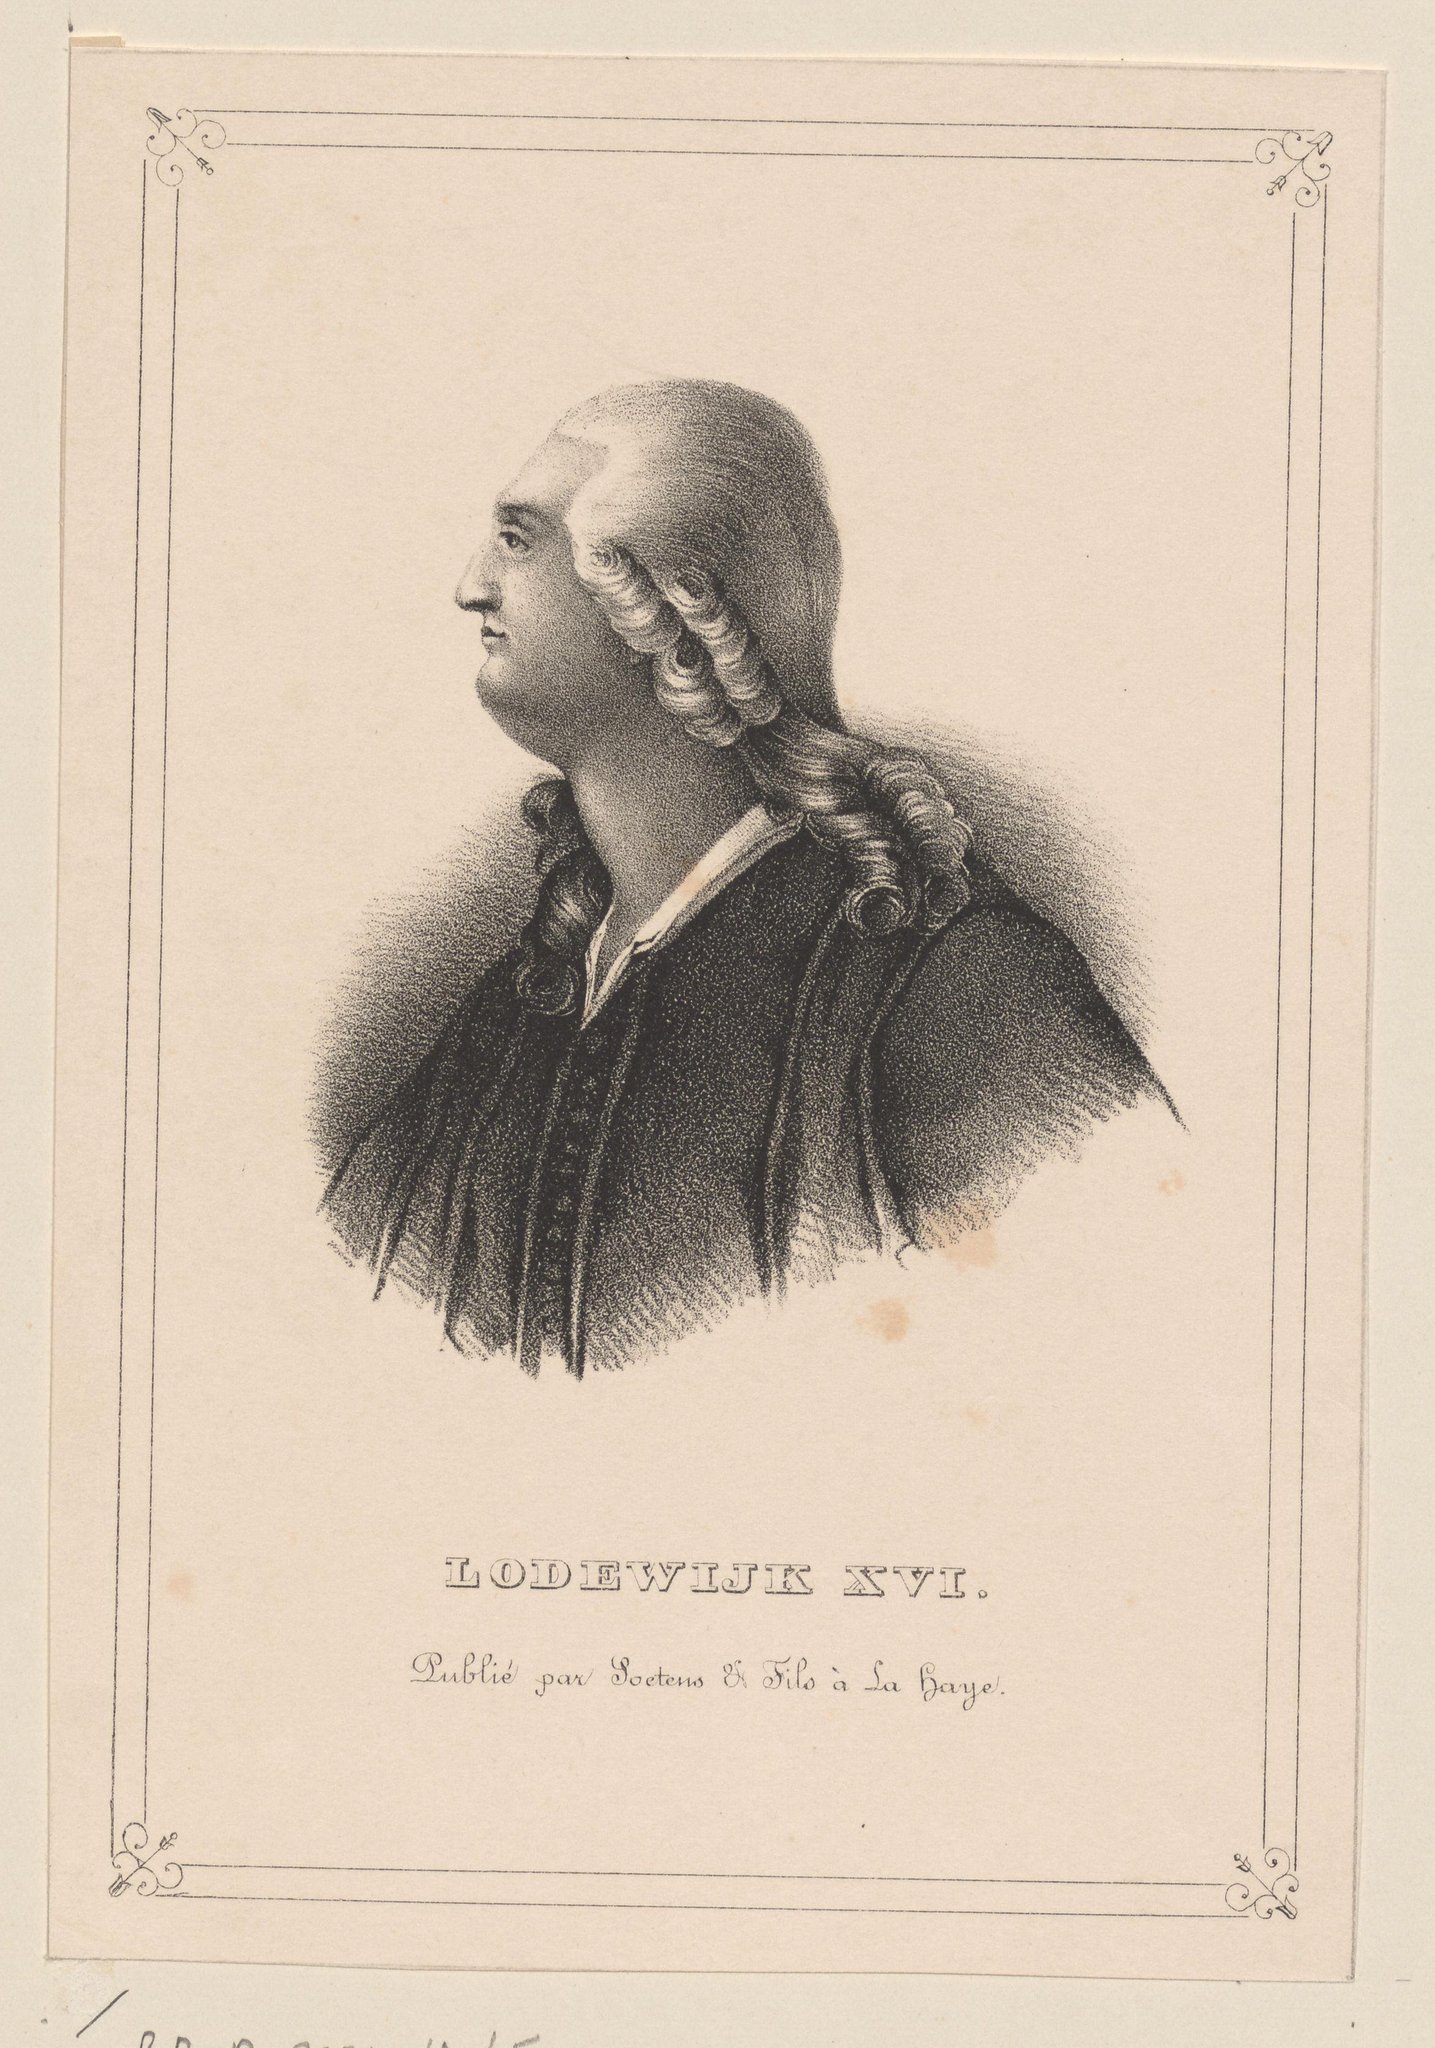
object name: print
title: Serie portretten door Soetens & Fils uit 1838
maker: Anonymous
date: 1837-1840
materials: paper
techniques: lithograph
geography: the hague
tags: paris, lodewijk xvi (koning van frankrijk), historical persons, king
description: Deze prent maakte deel uit van een serie uitgegeven door Soetens et Fils omstreeks 1838, opgedragen aan de Prins van Oranje. In de 'Prospectus en Inteekenlijst' stond vermeld dat het zal bestaan uit een onbepaald aantal portretten, waarvan er drie of vier per maand verschijnen. Zie Van Someren.